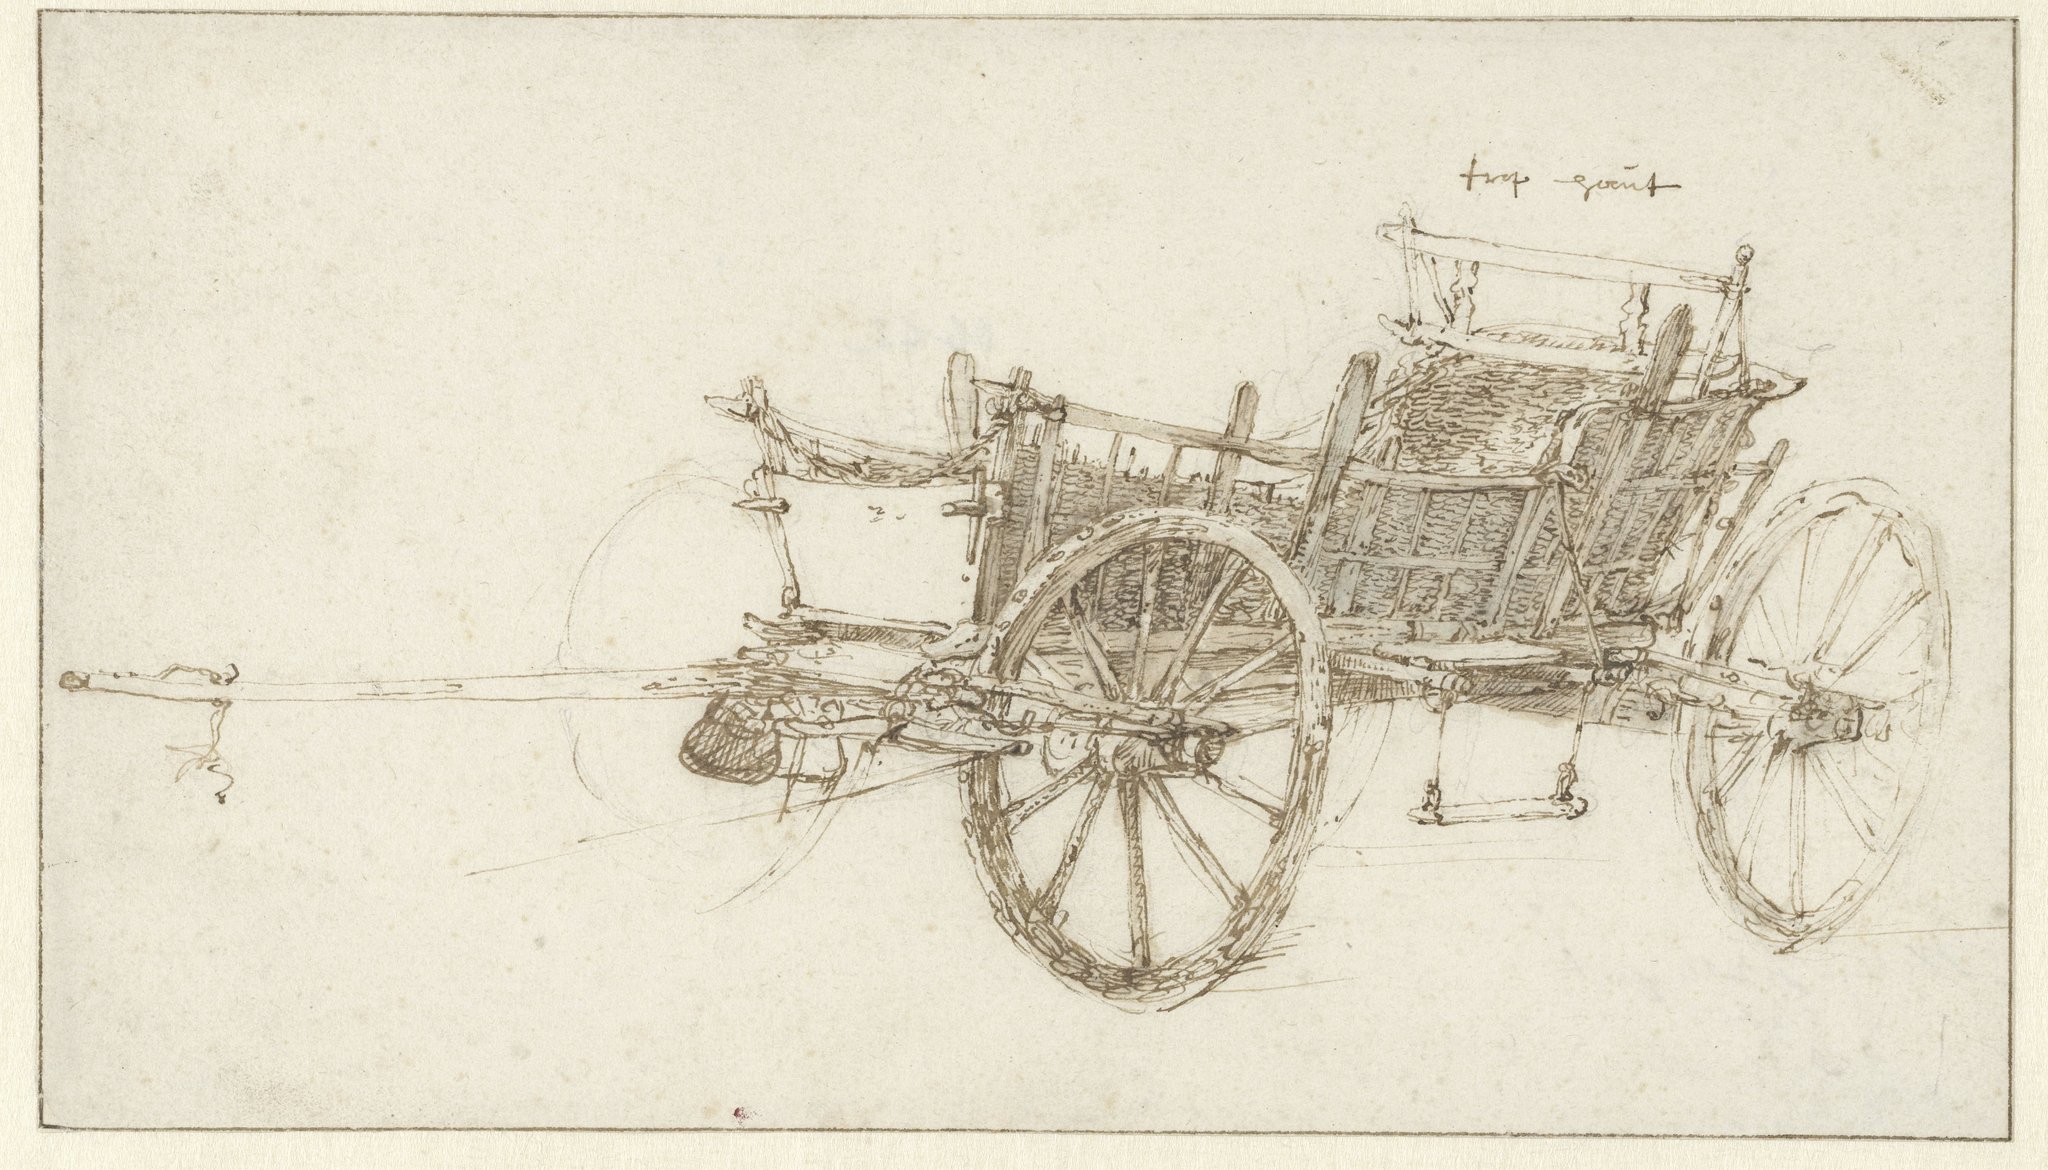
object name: drawing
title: A Wagon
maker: isaac van ostade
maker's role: draughtsman, painter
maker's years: 1621-1649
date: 1645-1649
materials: ink, paper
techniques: brush, pen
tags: (farm) wagon, freight wagon, cart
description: A number of minutely observed studies of carts and wagons by Isaac van Ostade have survived. The artist rendered the smallest details of these often-ramshackle vehicles with a finely pointed pen. Presumably Isaac made these drawings with the intention of one day using them in a larger composition, whether a painting or a drawing.